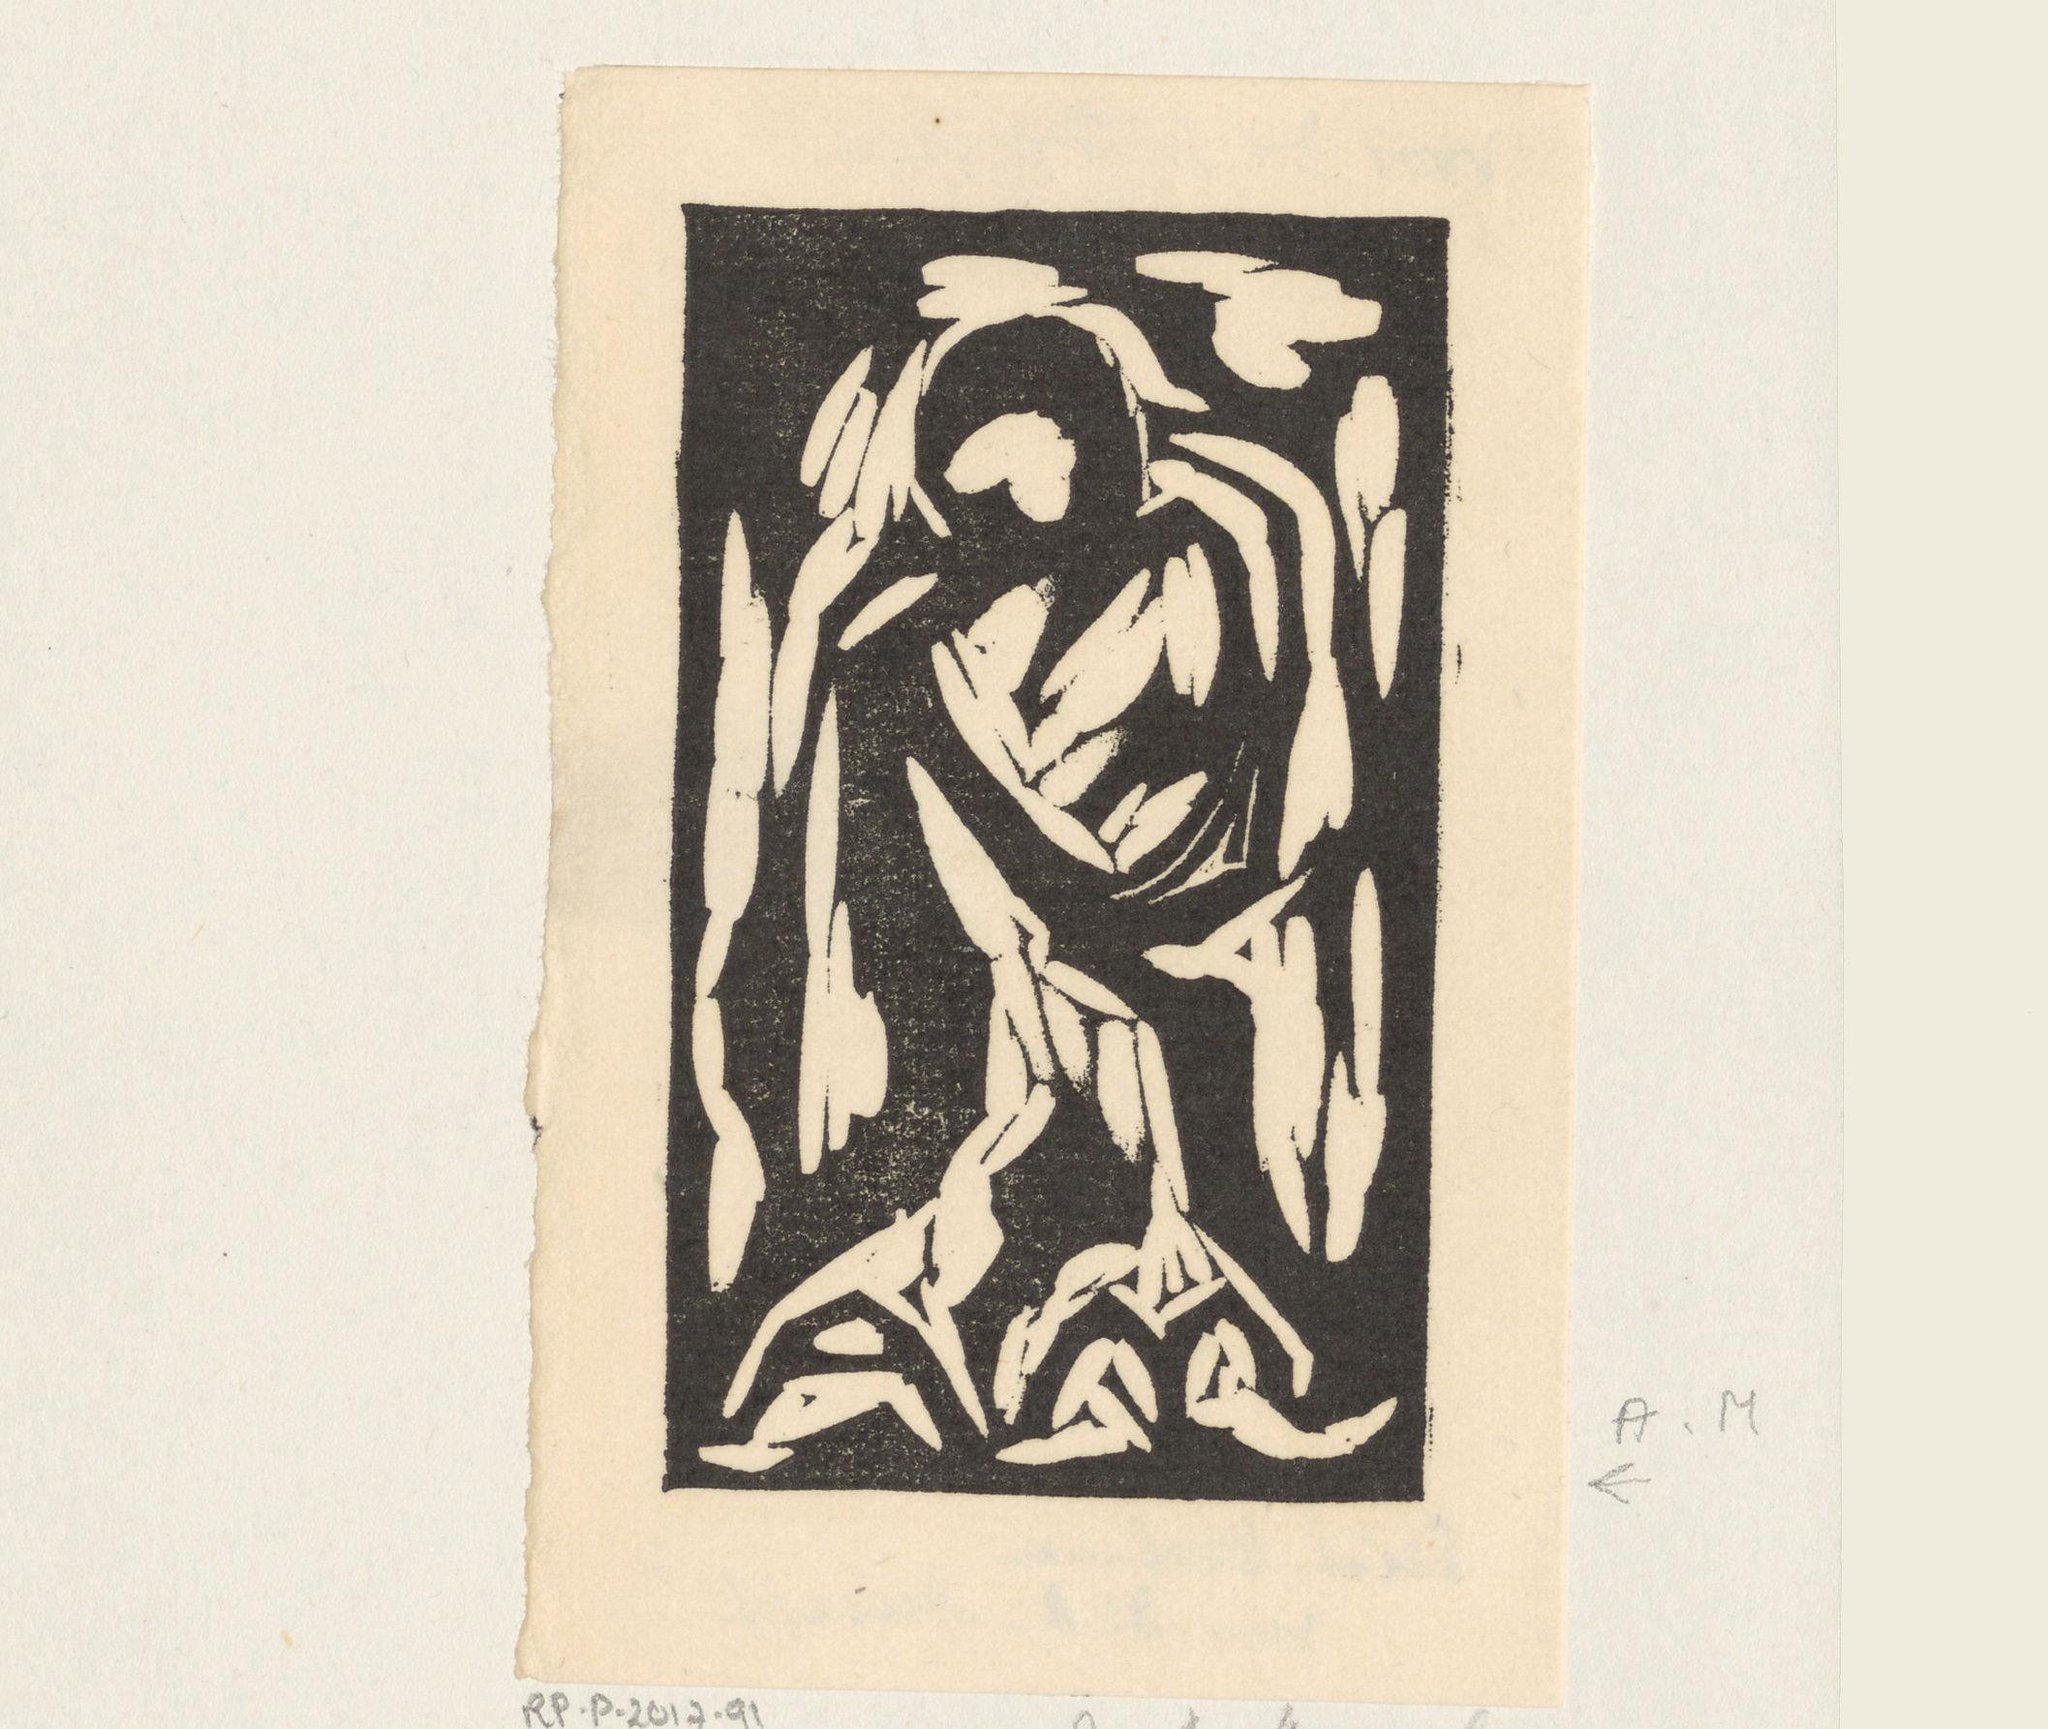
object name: bookplate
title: Ex libris van A. Musaph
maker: erich wichmann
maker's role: print maker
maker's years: 1890-1929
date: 1900-1929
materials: paper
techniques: linocut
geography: netherlands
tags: kneeling figure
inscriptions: inscription: ‘Erich Wichman / voor Dr. A. Musaph’